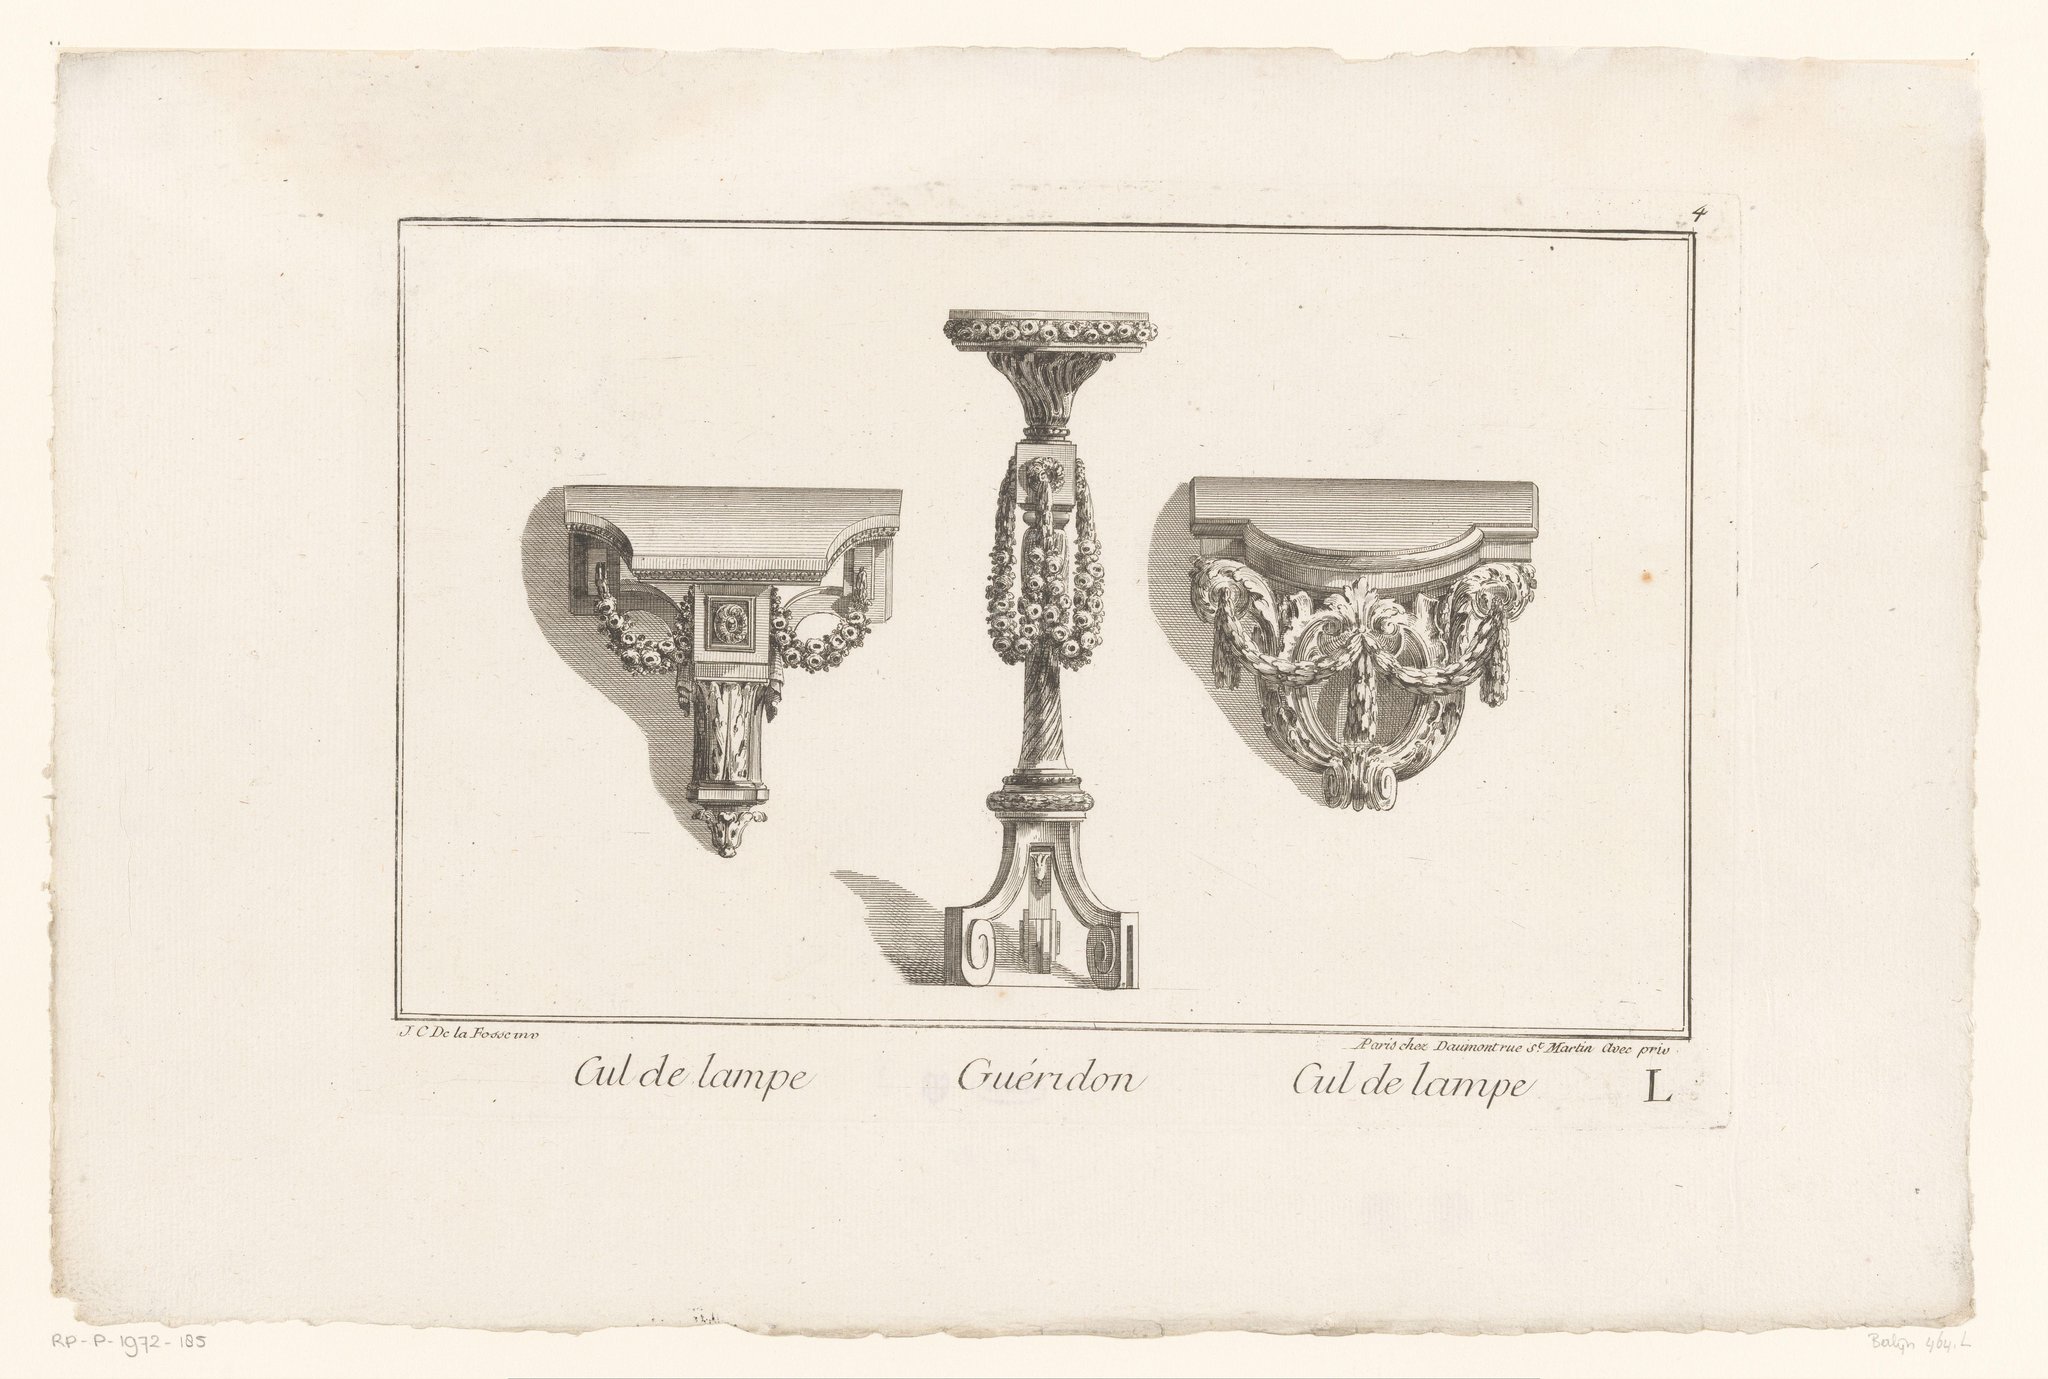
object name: print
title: Gueridon en cul-de-lampes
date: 1745-1775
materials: paper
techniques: engraving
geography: paris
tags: other architectural details (console), table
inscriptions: collector's mark: Lugt 2228, collector's mark: Lugt 2760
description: Een gueridon met guirlandes. Aan weerszijden een cul-de-lampe met guirlandes.